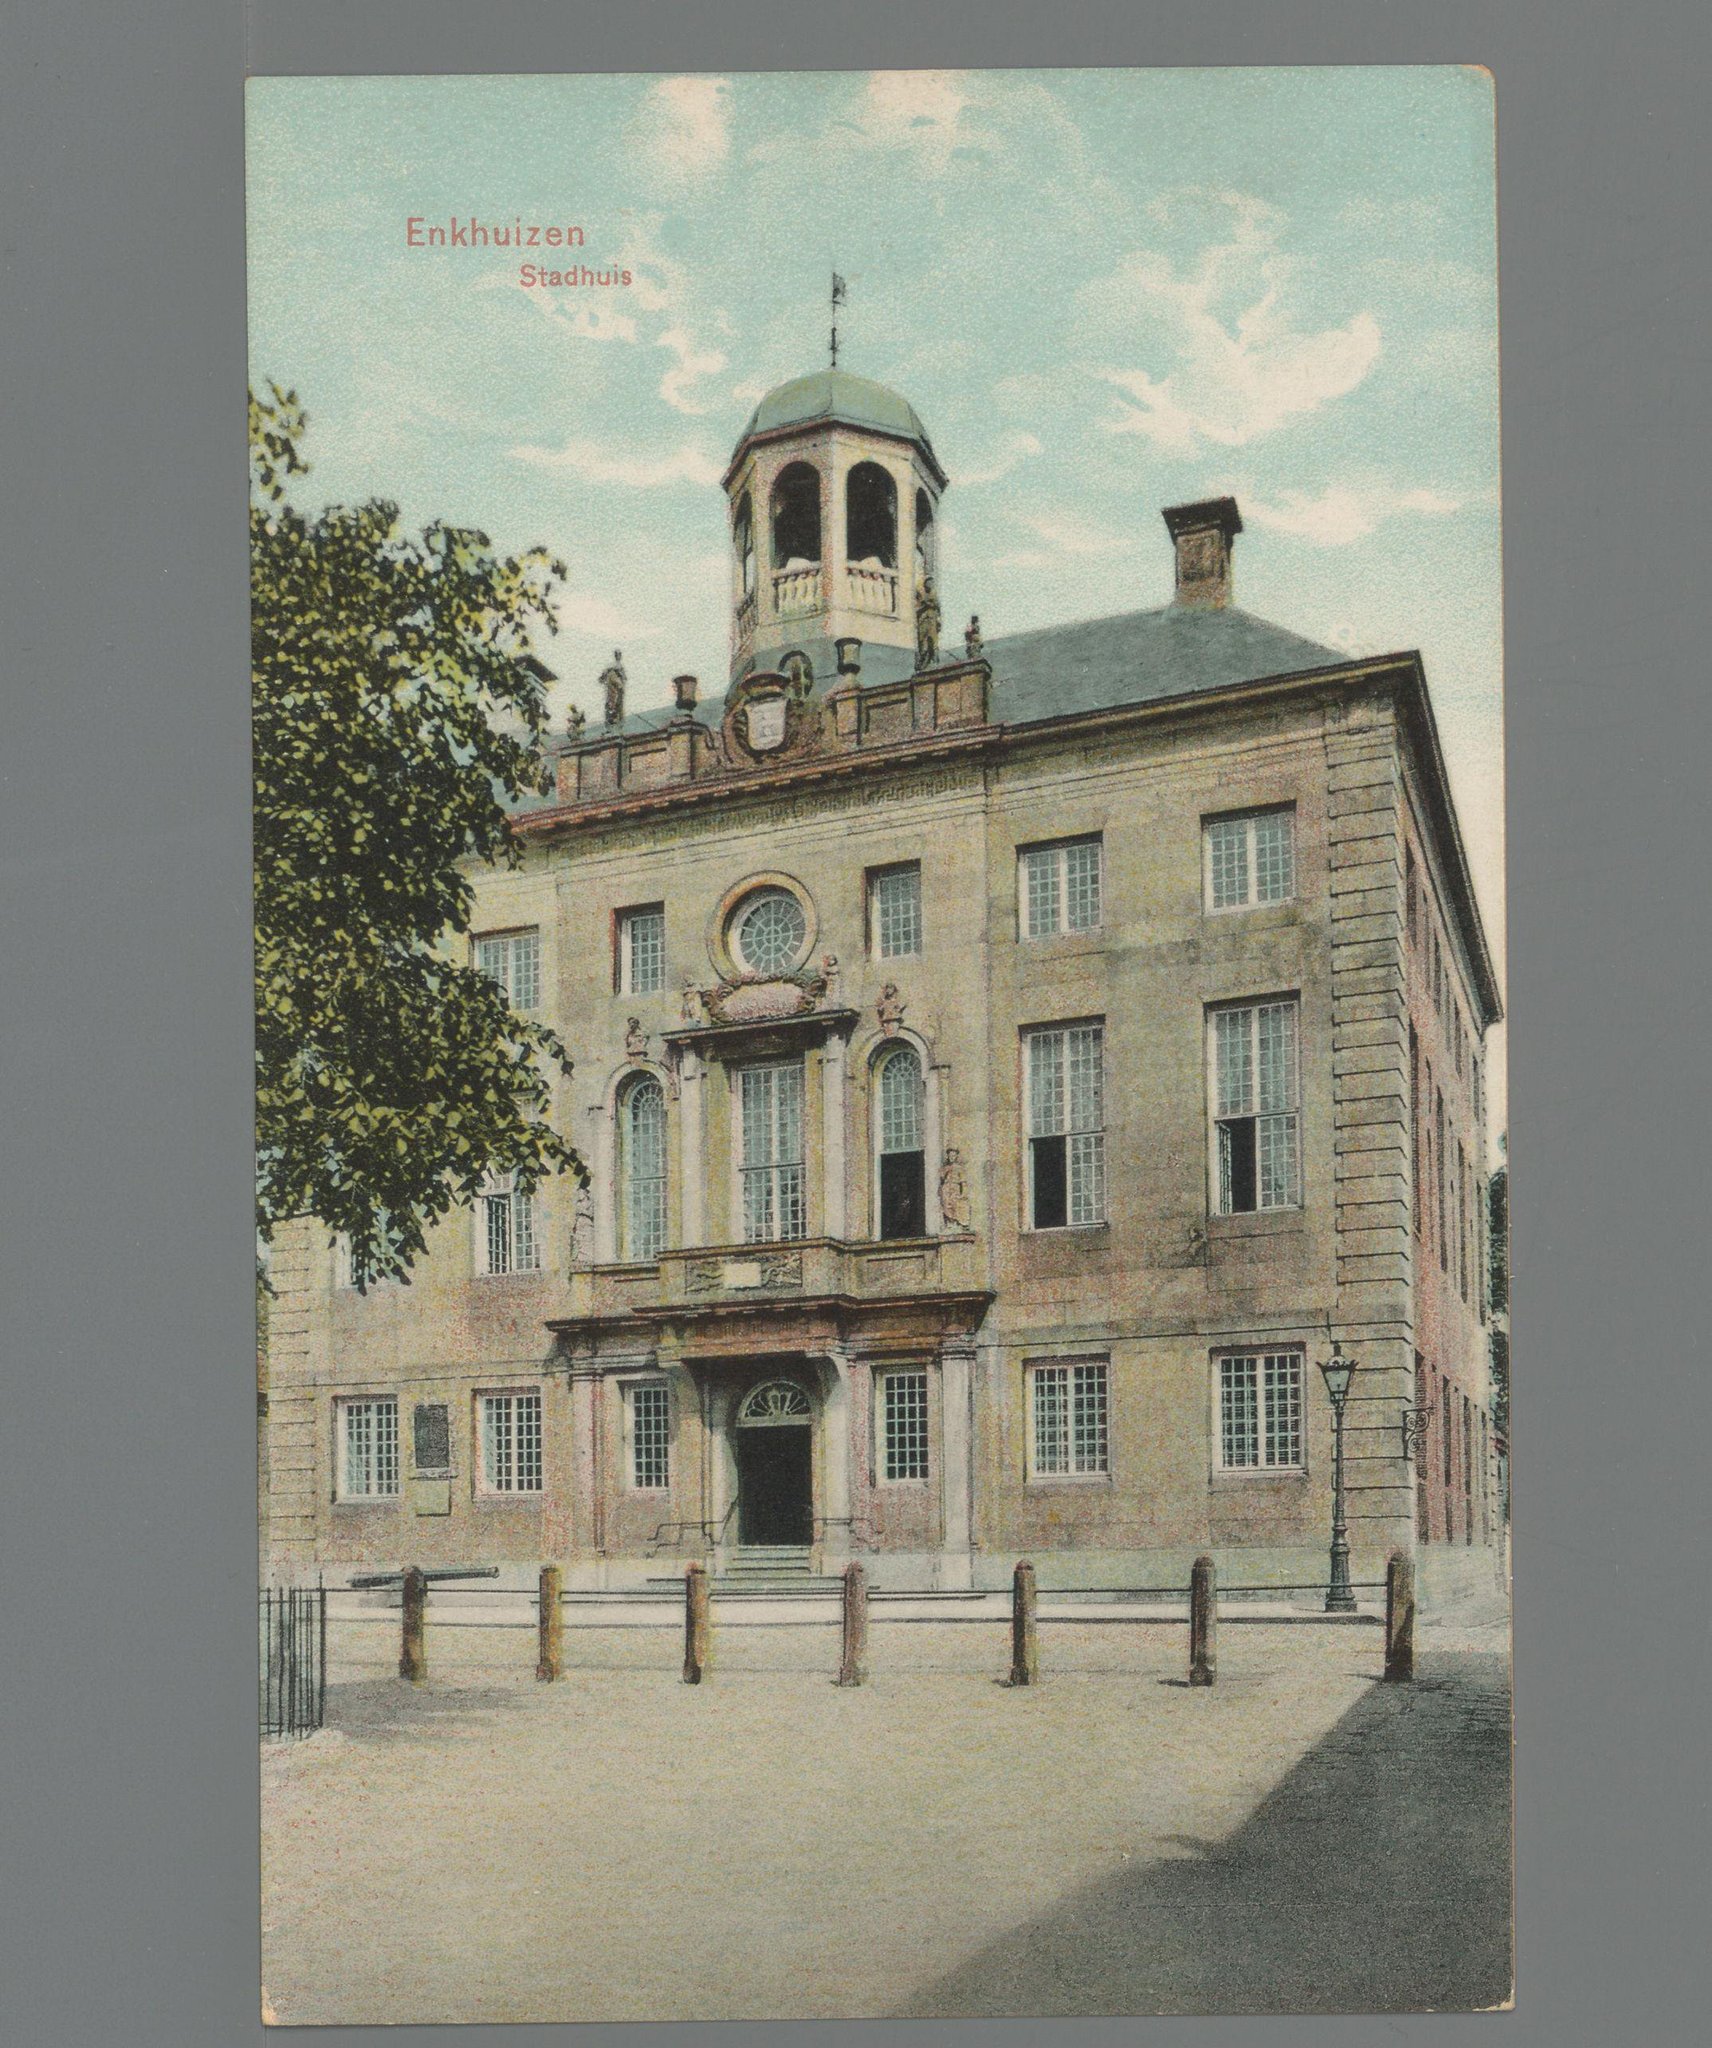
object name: photomechanical print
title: Enkhuizen. Stadhuis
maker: Anonymous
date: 1912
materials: cardboard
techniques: photograph, lithograph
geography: leipzig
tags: townhall, enkhuizen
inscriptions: date